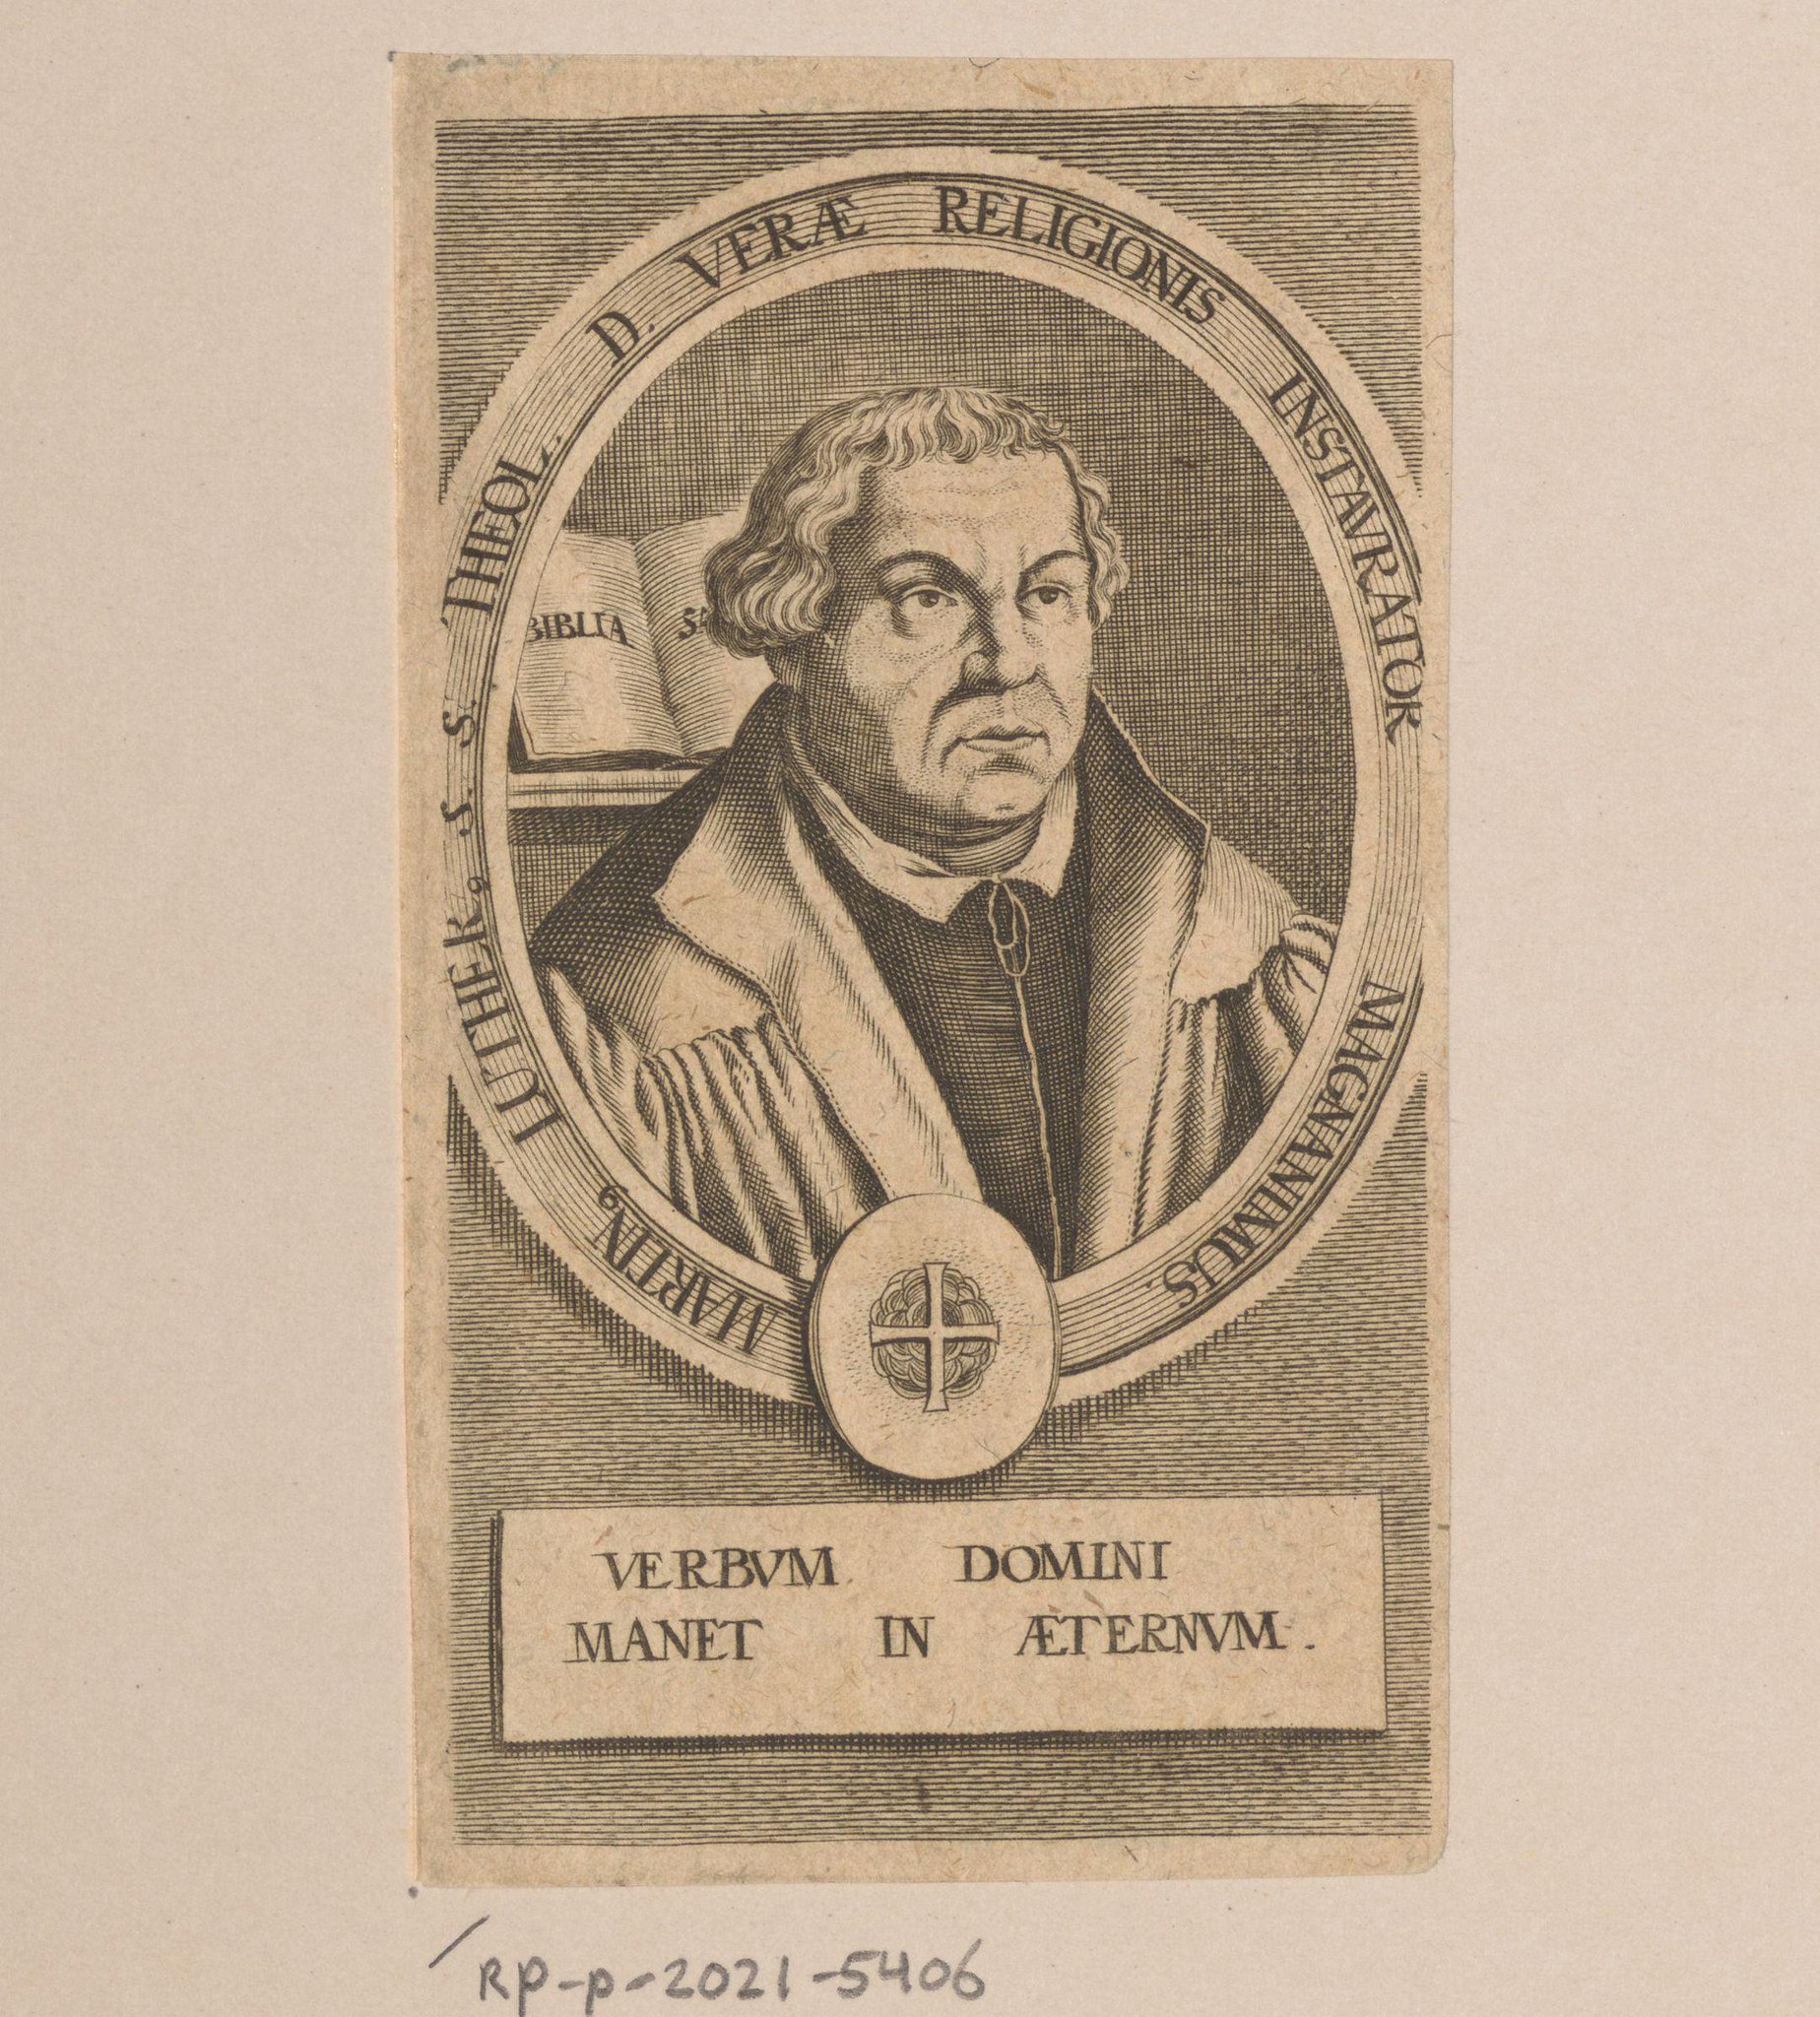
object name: print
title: Portret van Martin Luther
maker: Anonymous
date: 1650-1750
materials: paper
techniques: engraving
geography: germany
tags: priest, martin luther, theologian, ornament ~ medallion, historical persons, the bible as a book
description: Met tekst in het Latijn rondom en onder het portret.